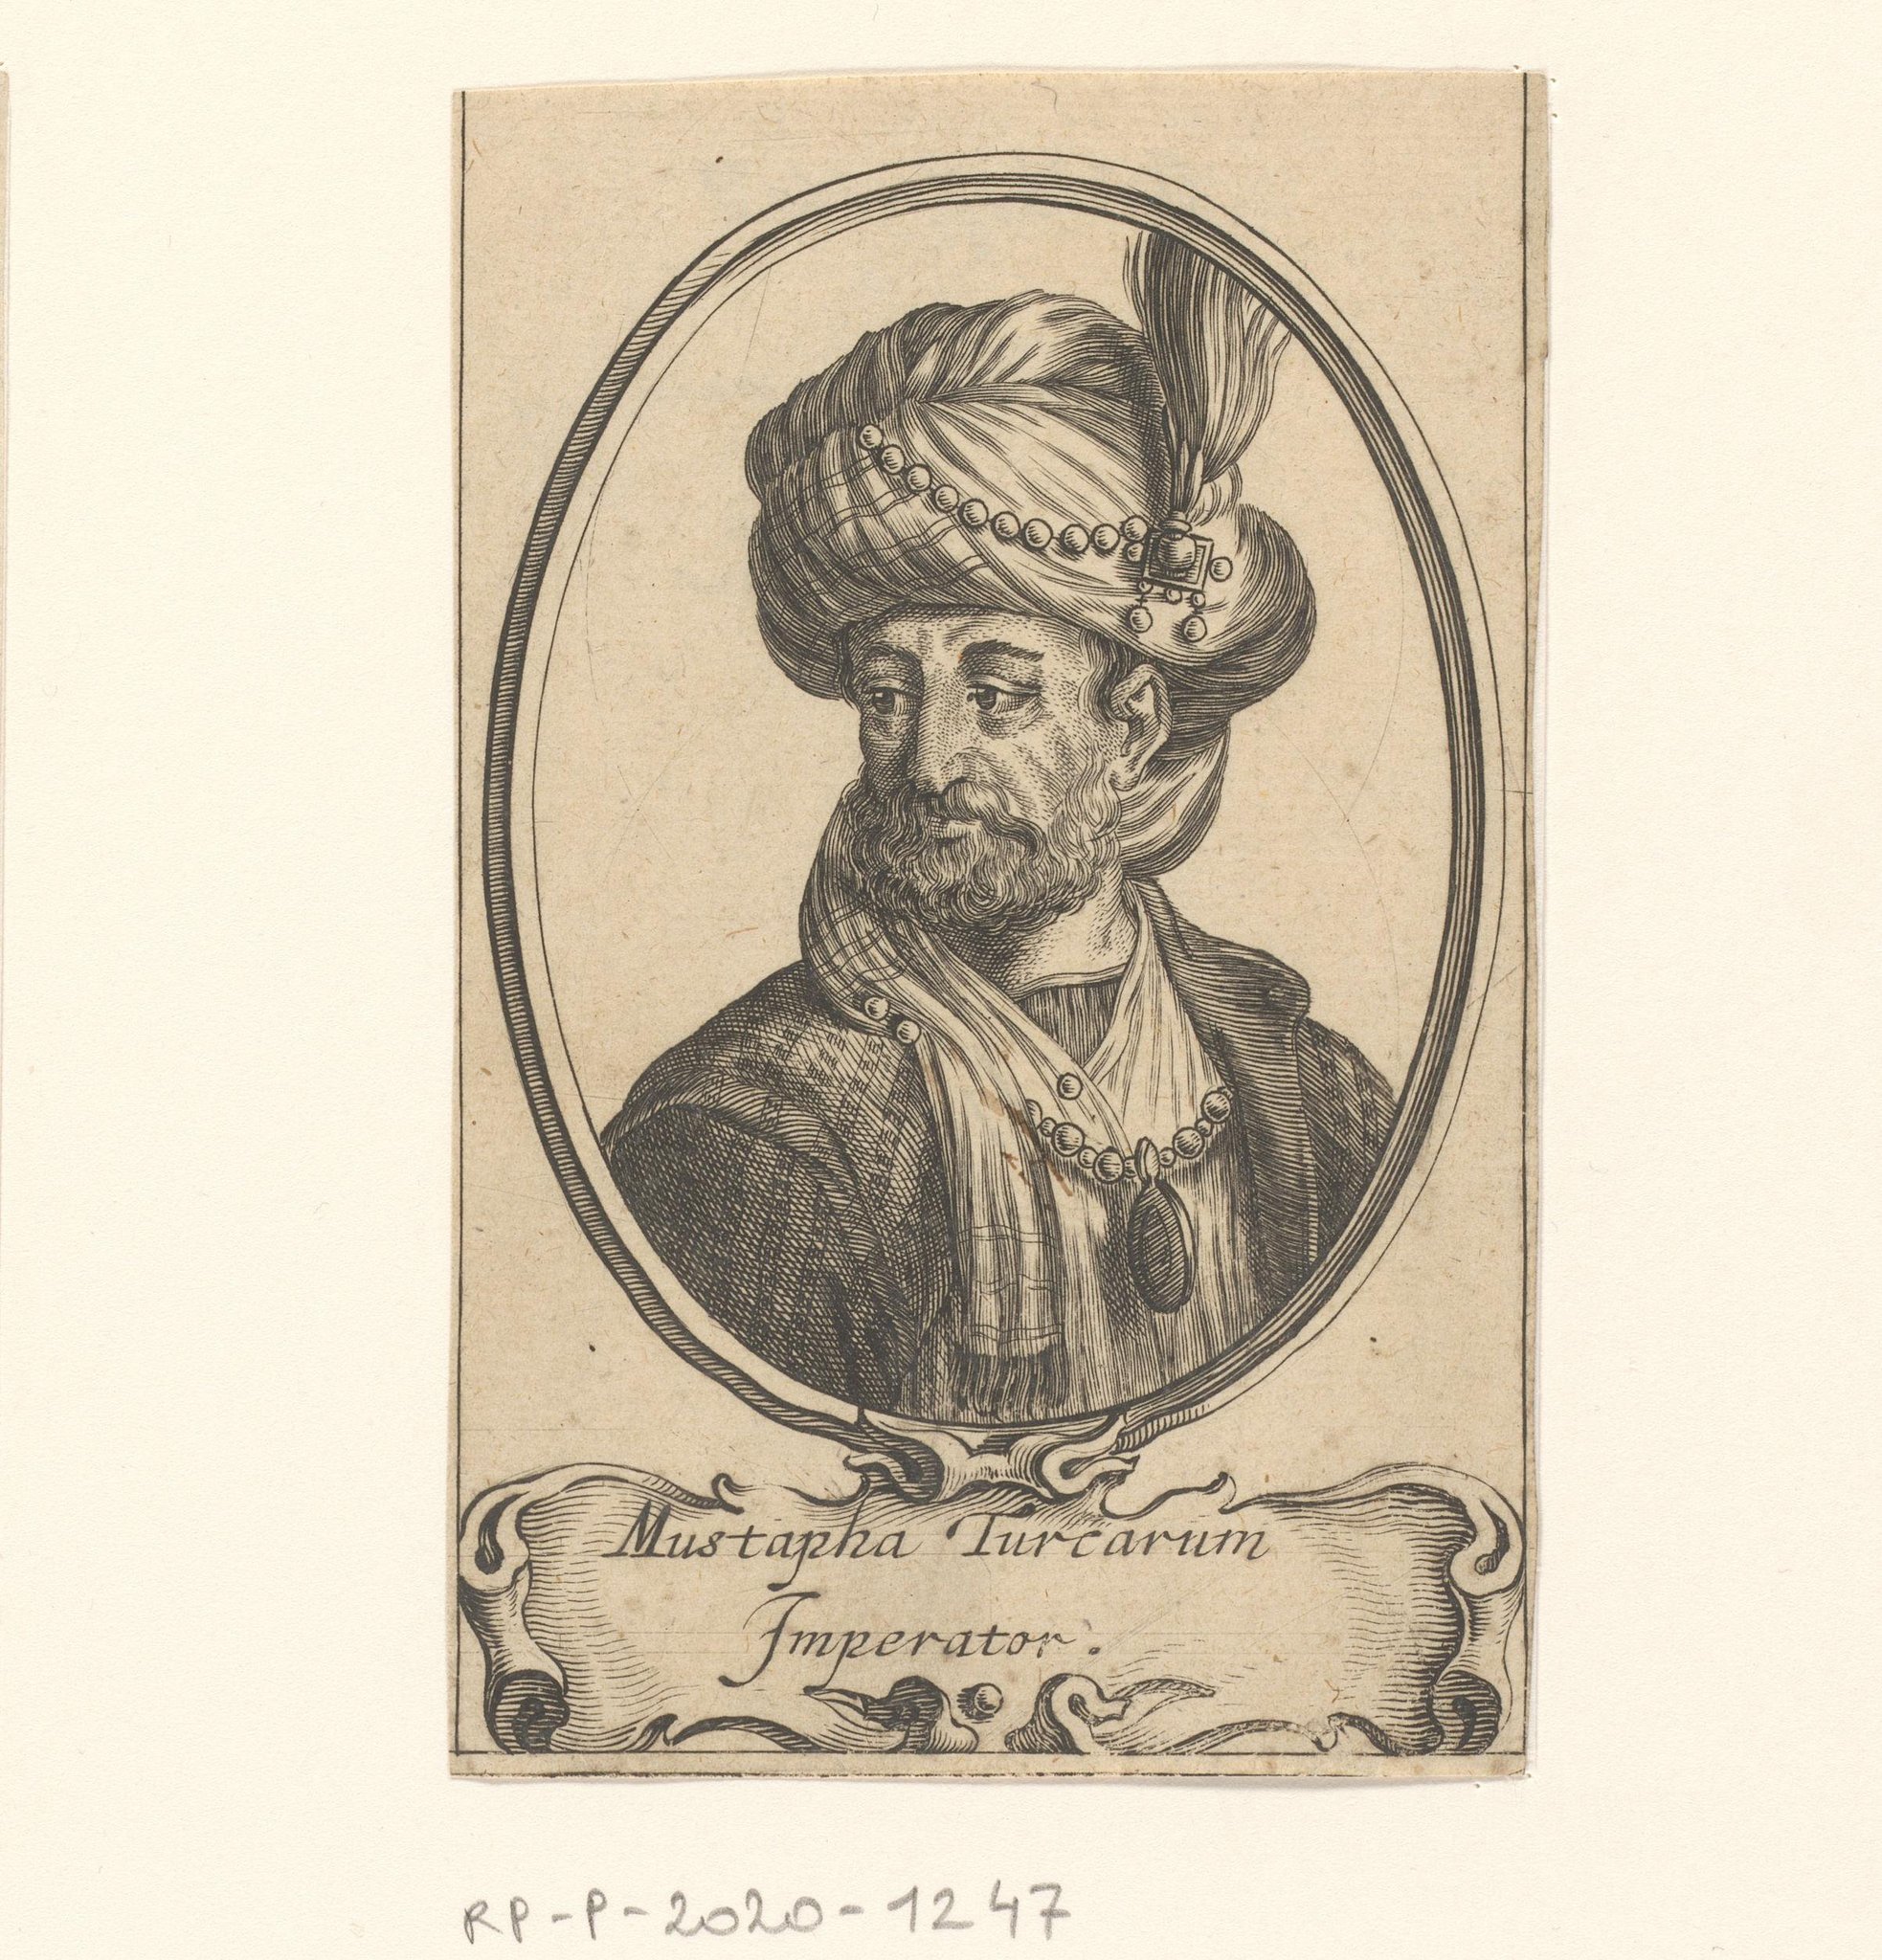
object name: book illustration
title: Mustapha Turcarum imperator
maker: Anonymous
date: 1656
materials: paper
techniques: engraving, etching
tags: historical persons, head-gear: turban, emperor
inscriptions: inscription: ‘4’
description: Prent gebruikt in: Bos, Lambert van den. Het konincklyk treur-toonneel, ofte op- en ondergangh der keyseren, koningen en vorsten (...). Dordrecht: Jacobus Savry, 1656, dl. 1, p. 589.